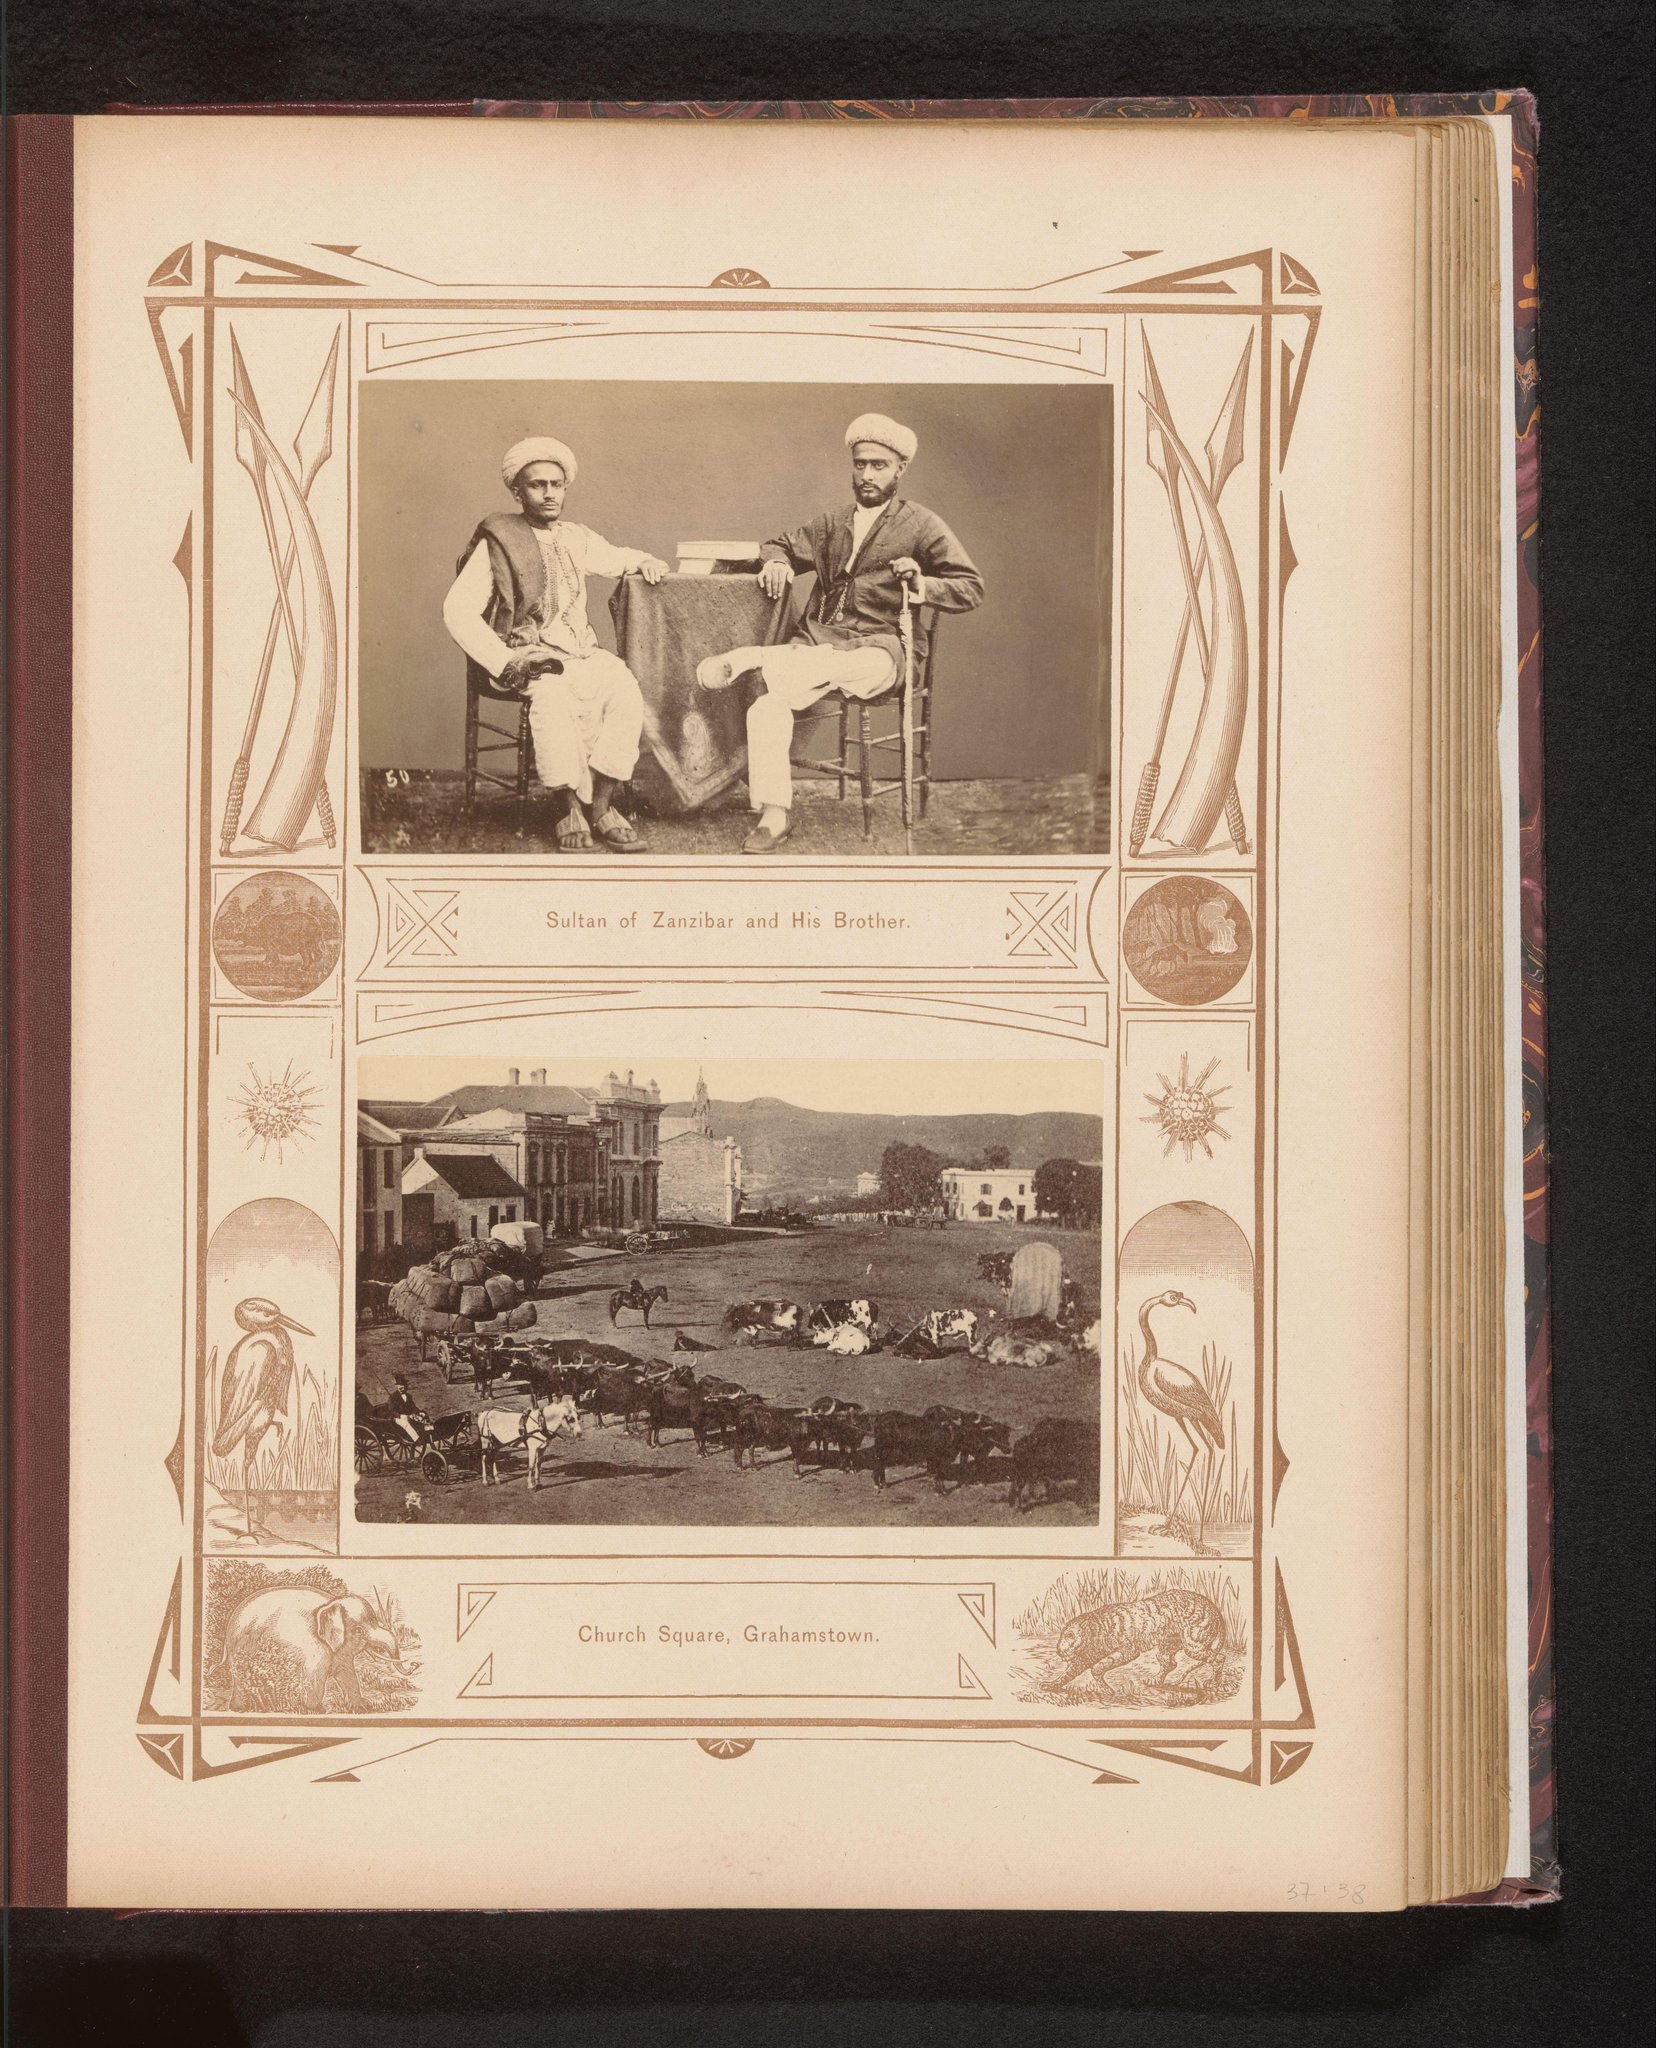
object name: photograph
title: Sultan of Zanzibar and his brother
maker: Anonymous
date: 1877-1882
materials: photographic support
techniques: albumen print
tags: adult man, historical persons, table